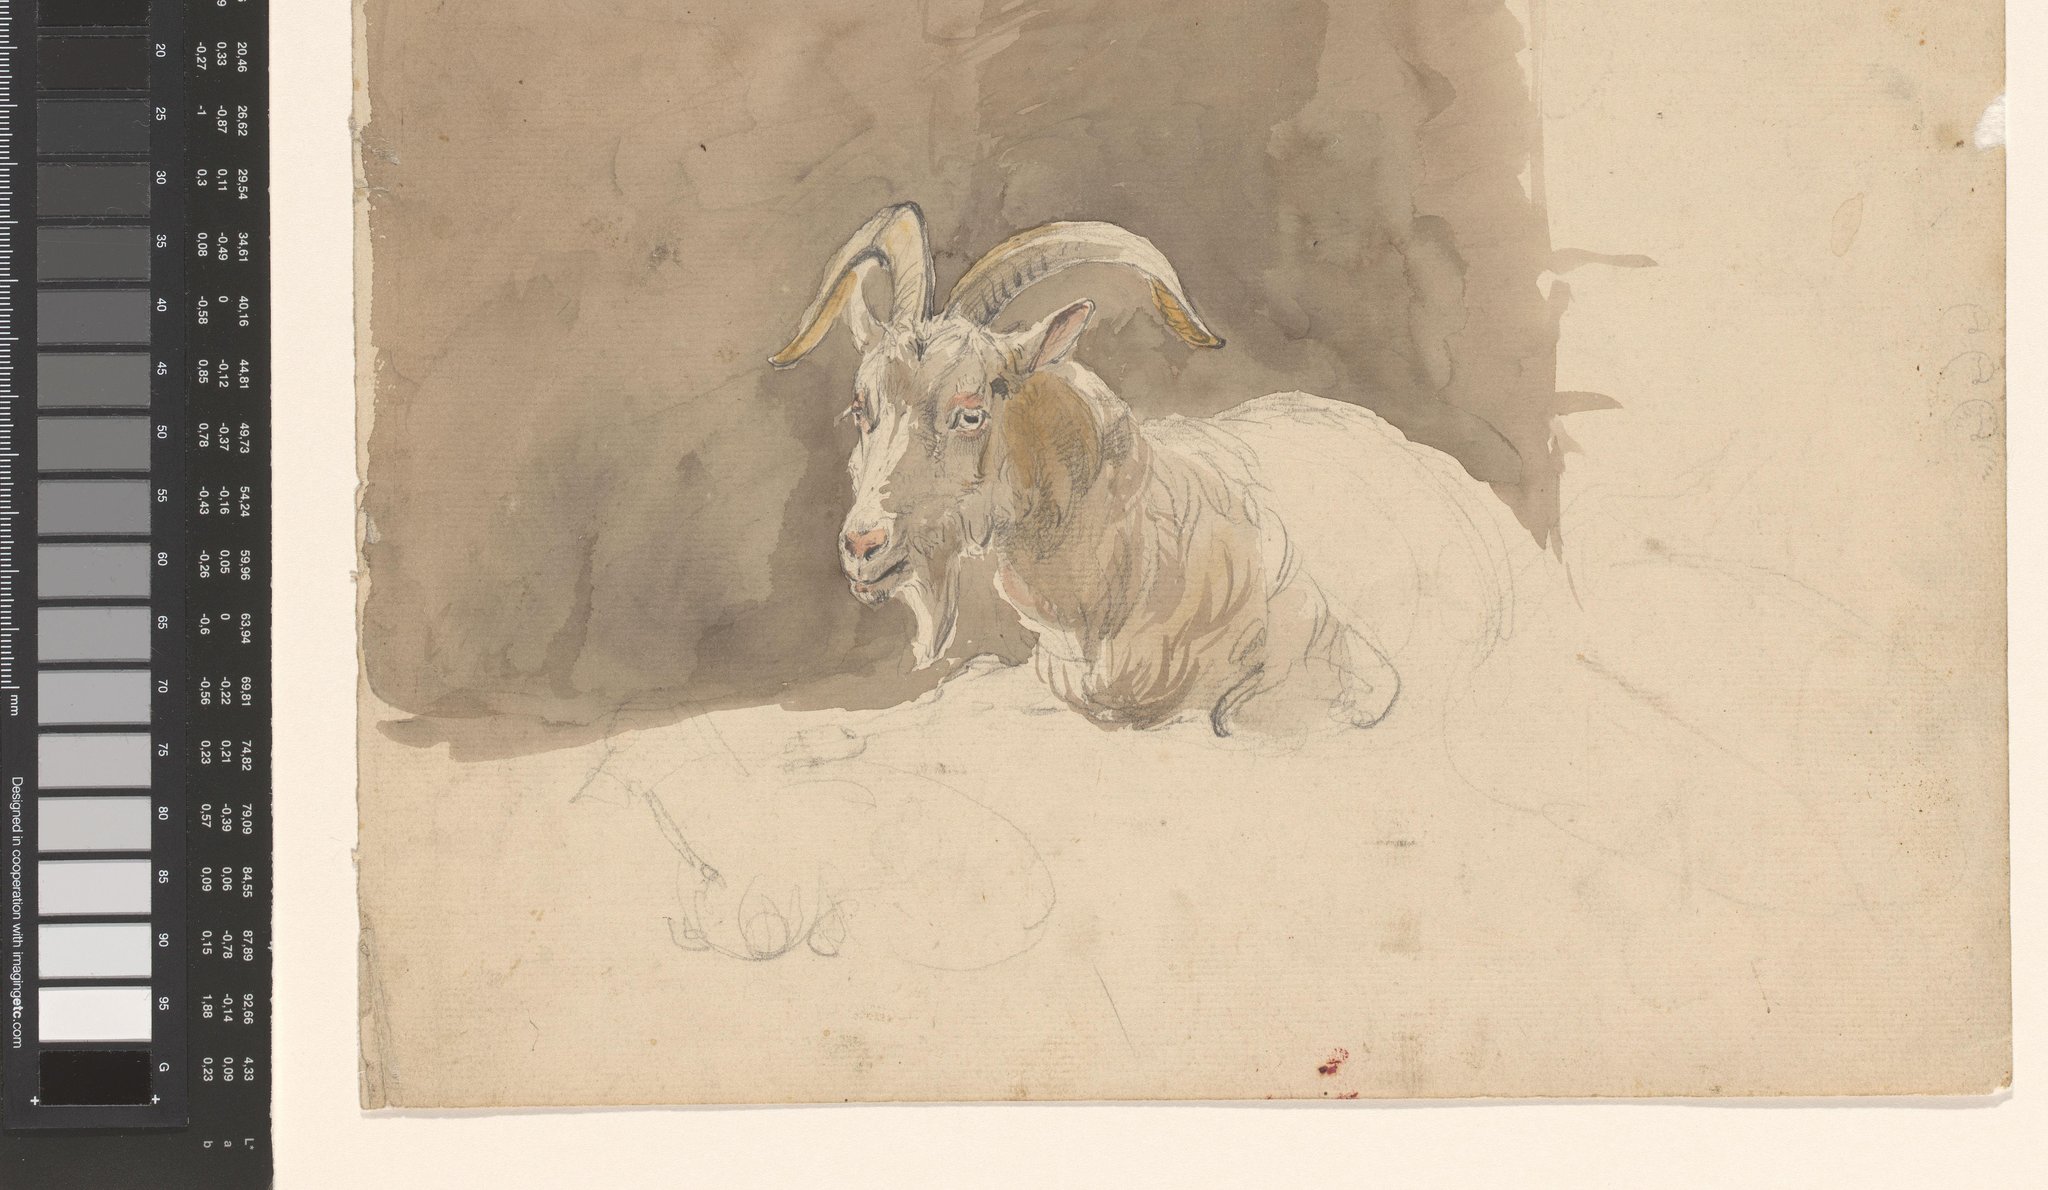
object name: drawing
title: Liggende geitenbok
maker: jan bedijs tom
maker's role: draughtsman, painter, print maker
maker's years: 1813-1894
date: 1823-1894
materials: paper, pencil, watercolor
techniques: brush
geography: the hague